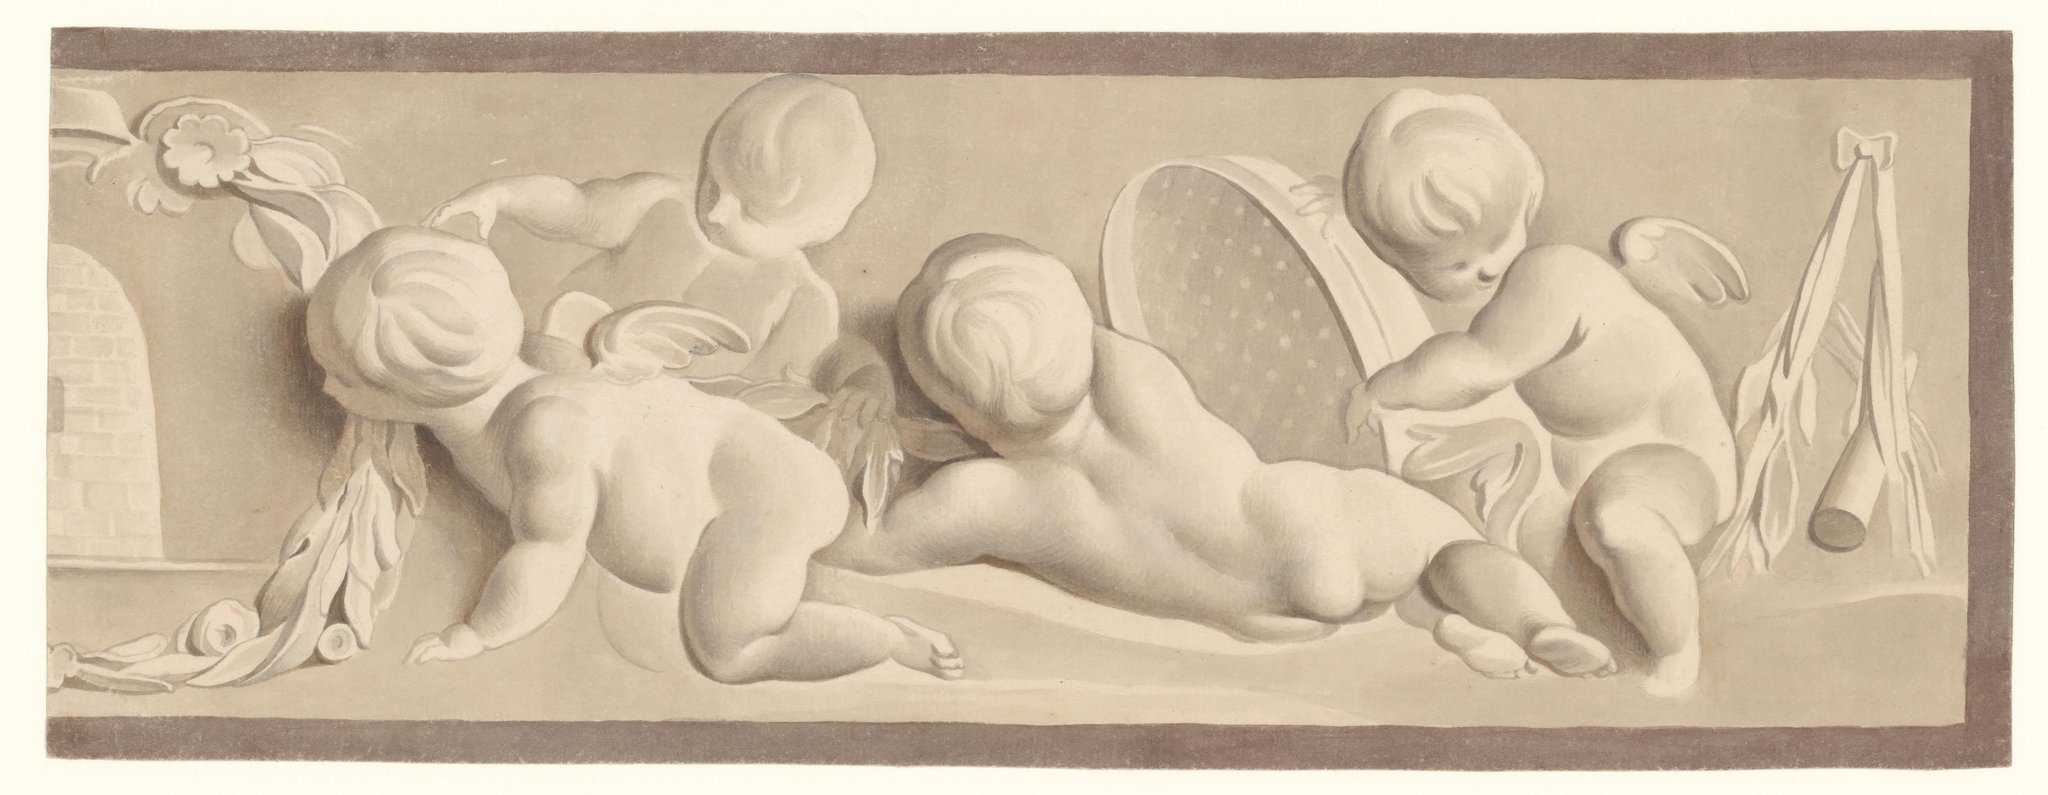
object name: drawing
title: Compositie met vier putti en een zeef, links een lauwerkrans en een bijenkorf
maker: hendrik pothoven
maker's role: draughtsman, painter, print maker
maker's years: 1725-1807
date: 1735-1807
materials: ink, paper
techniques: brush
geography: amsterdam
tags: cupids together with attributes of the arts, sciences, etc., townhall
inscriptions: collector's mark: ‘17’ Lugt 1641b, inscription: ‘Port. 17 - 381b’, inscription: ‘H Pothoven del. na[...] de Wet, berustende op de Raadkamer.’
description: Onderwerpsrubriek binnen de Atlas Amsterdam: Beeldhouw- en Schilderwerk.